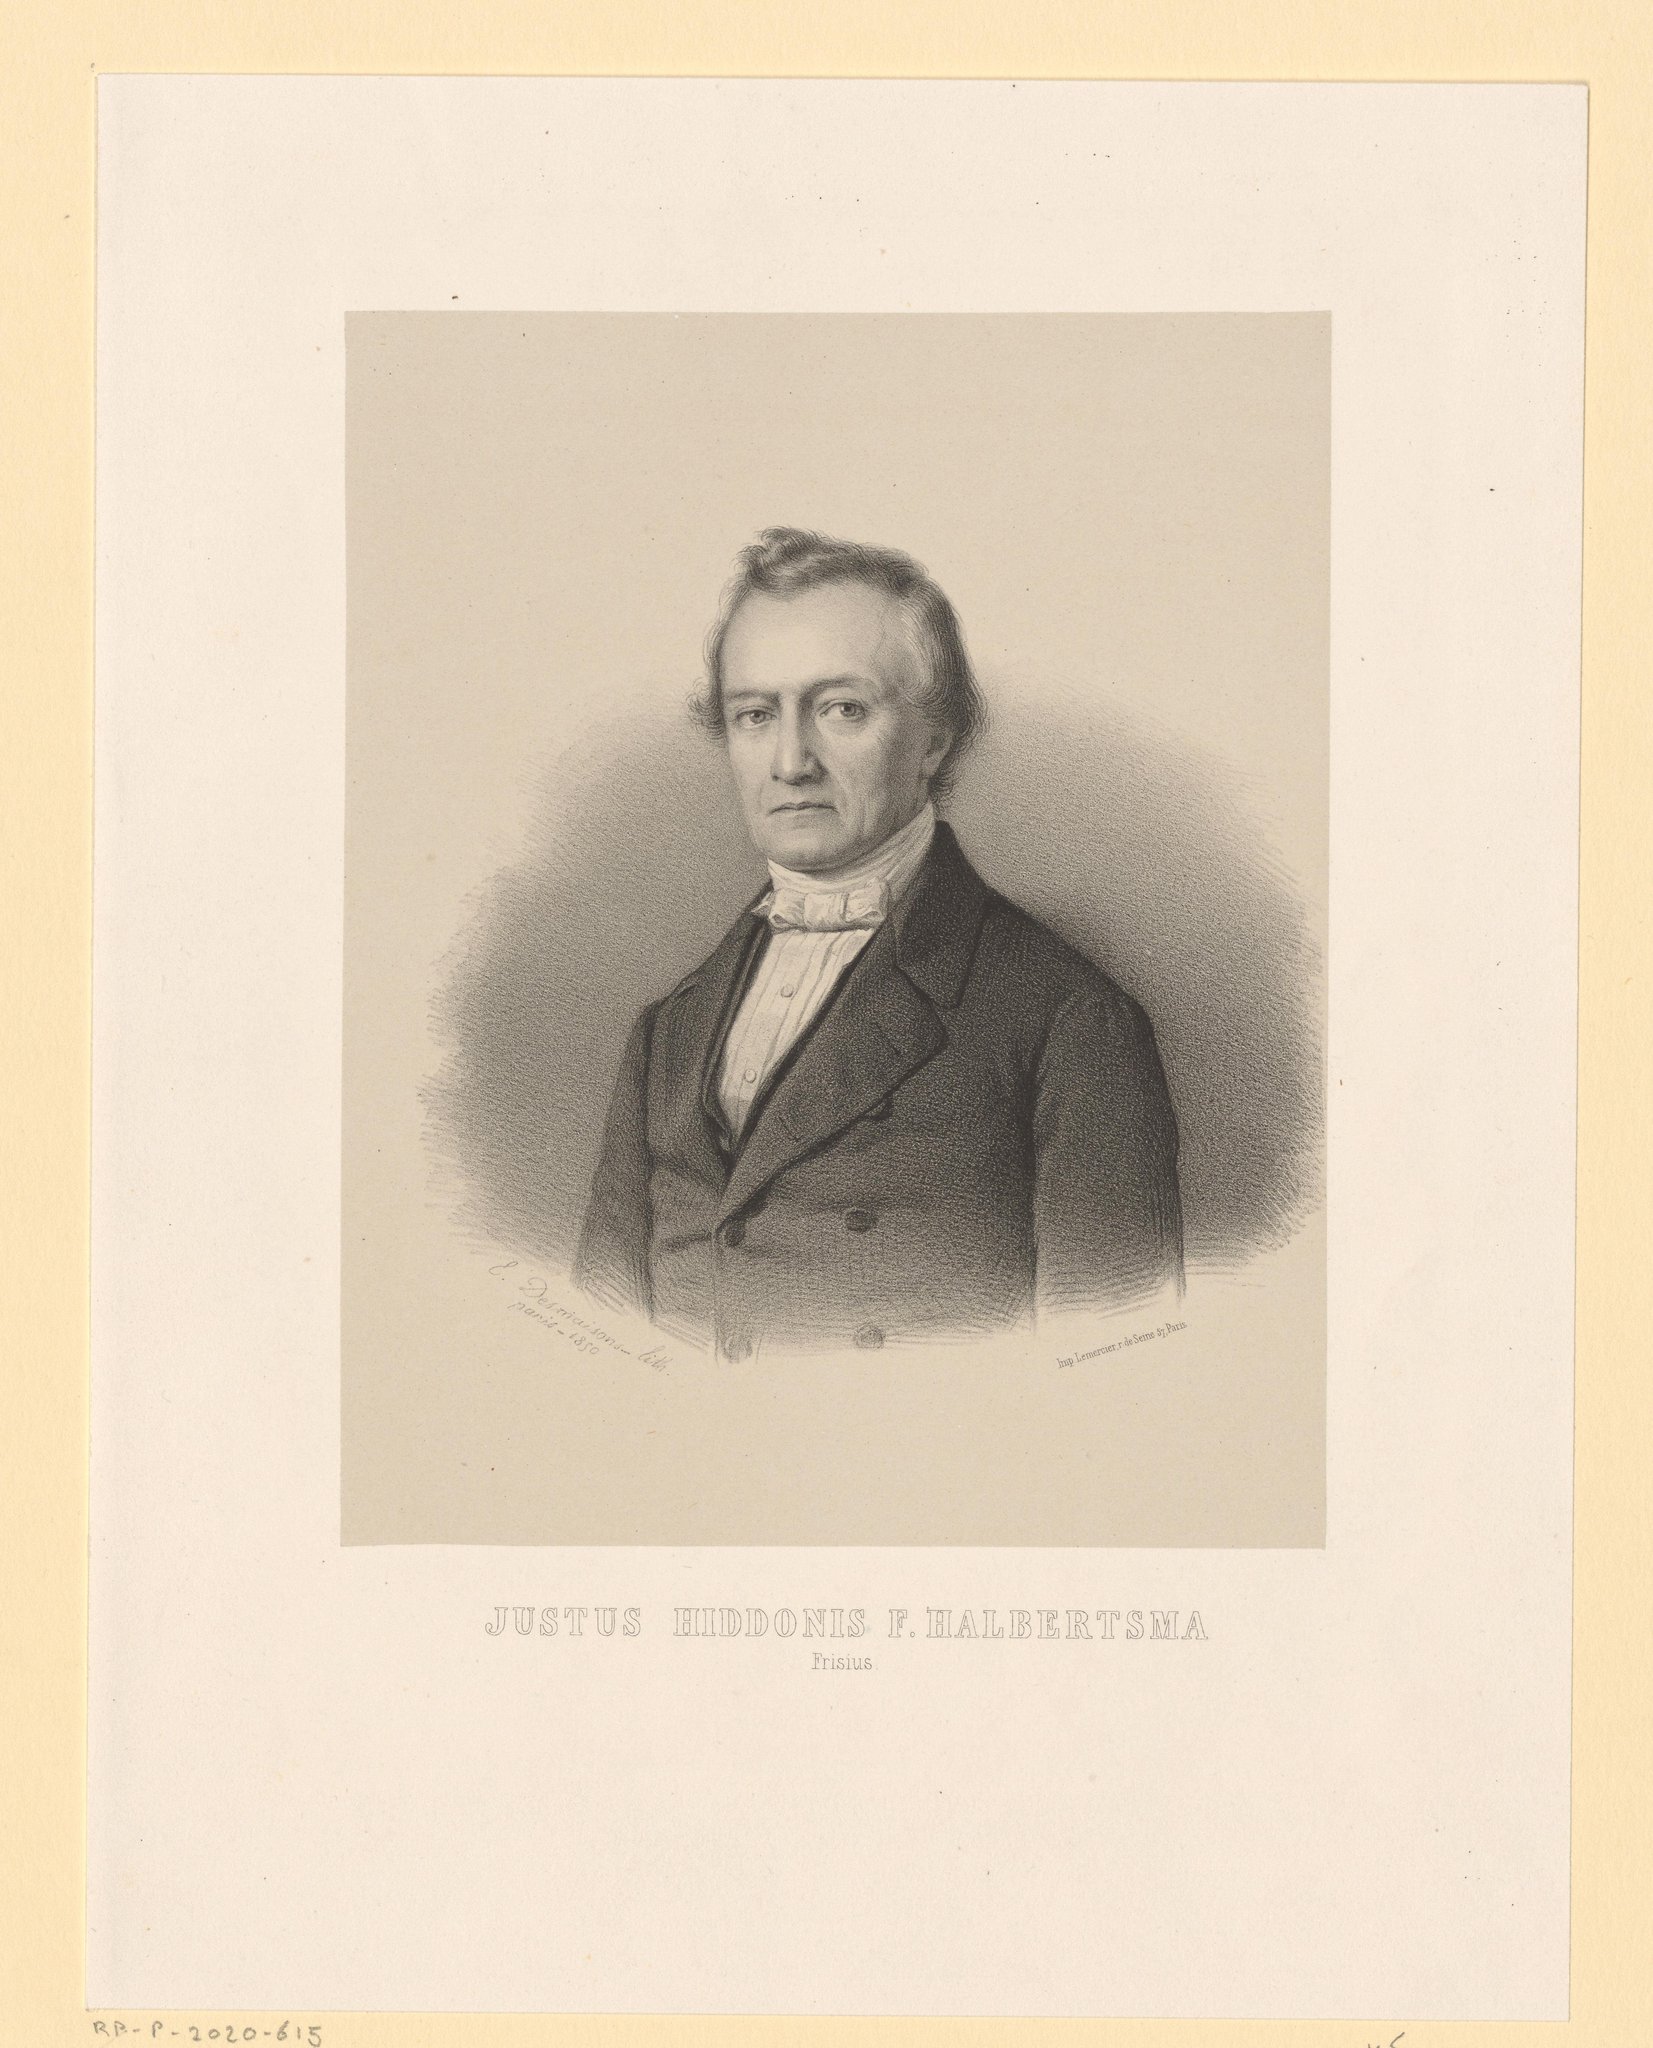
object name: print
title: Portret van Justus Hiddes Halbertsma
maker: émilien desmaisons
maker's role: draughtsman, print maker, publisher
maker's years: 1812-1880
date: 1850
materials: paper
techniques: lithograph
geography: paris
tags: deventer, historical persons, portrait of a writer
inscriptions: date